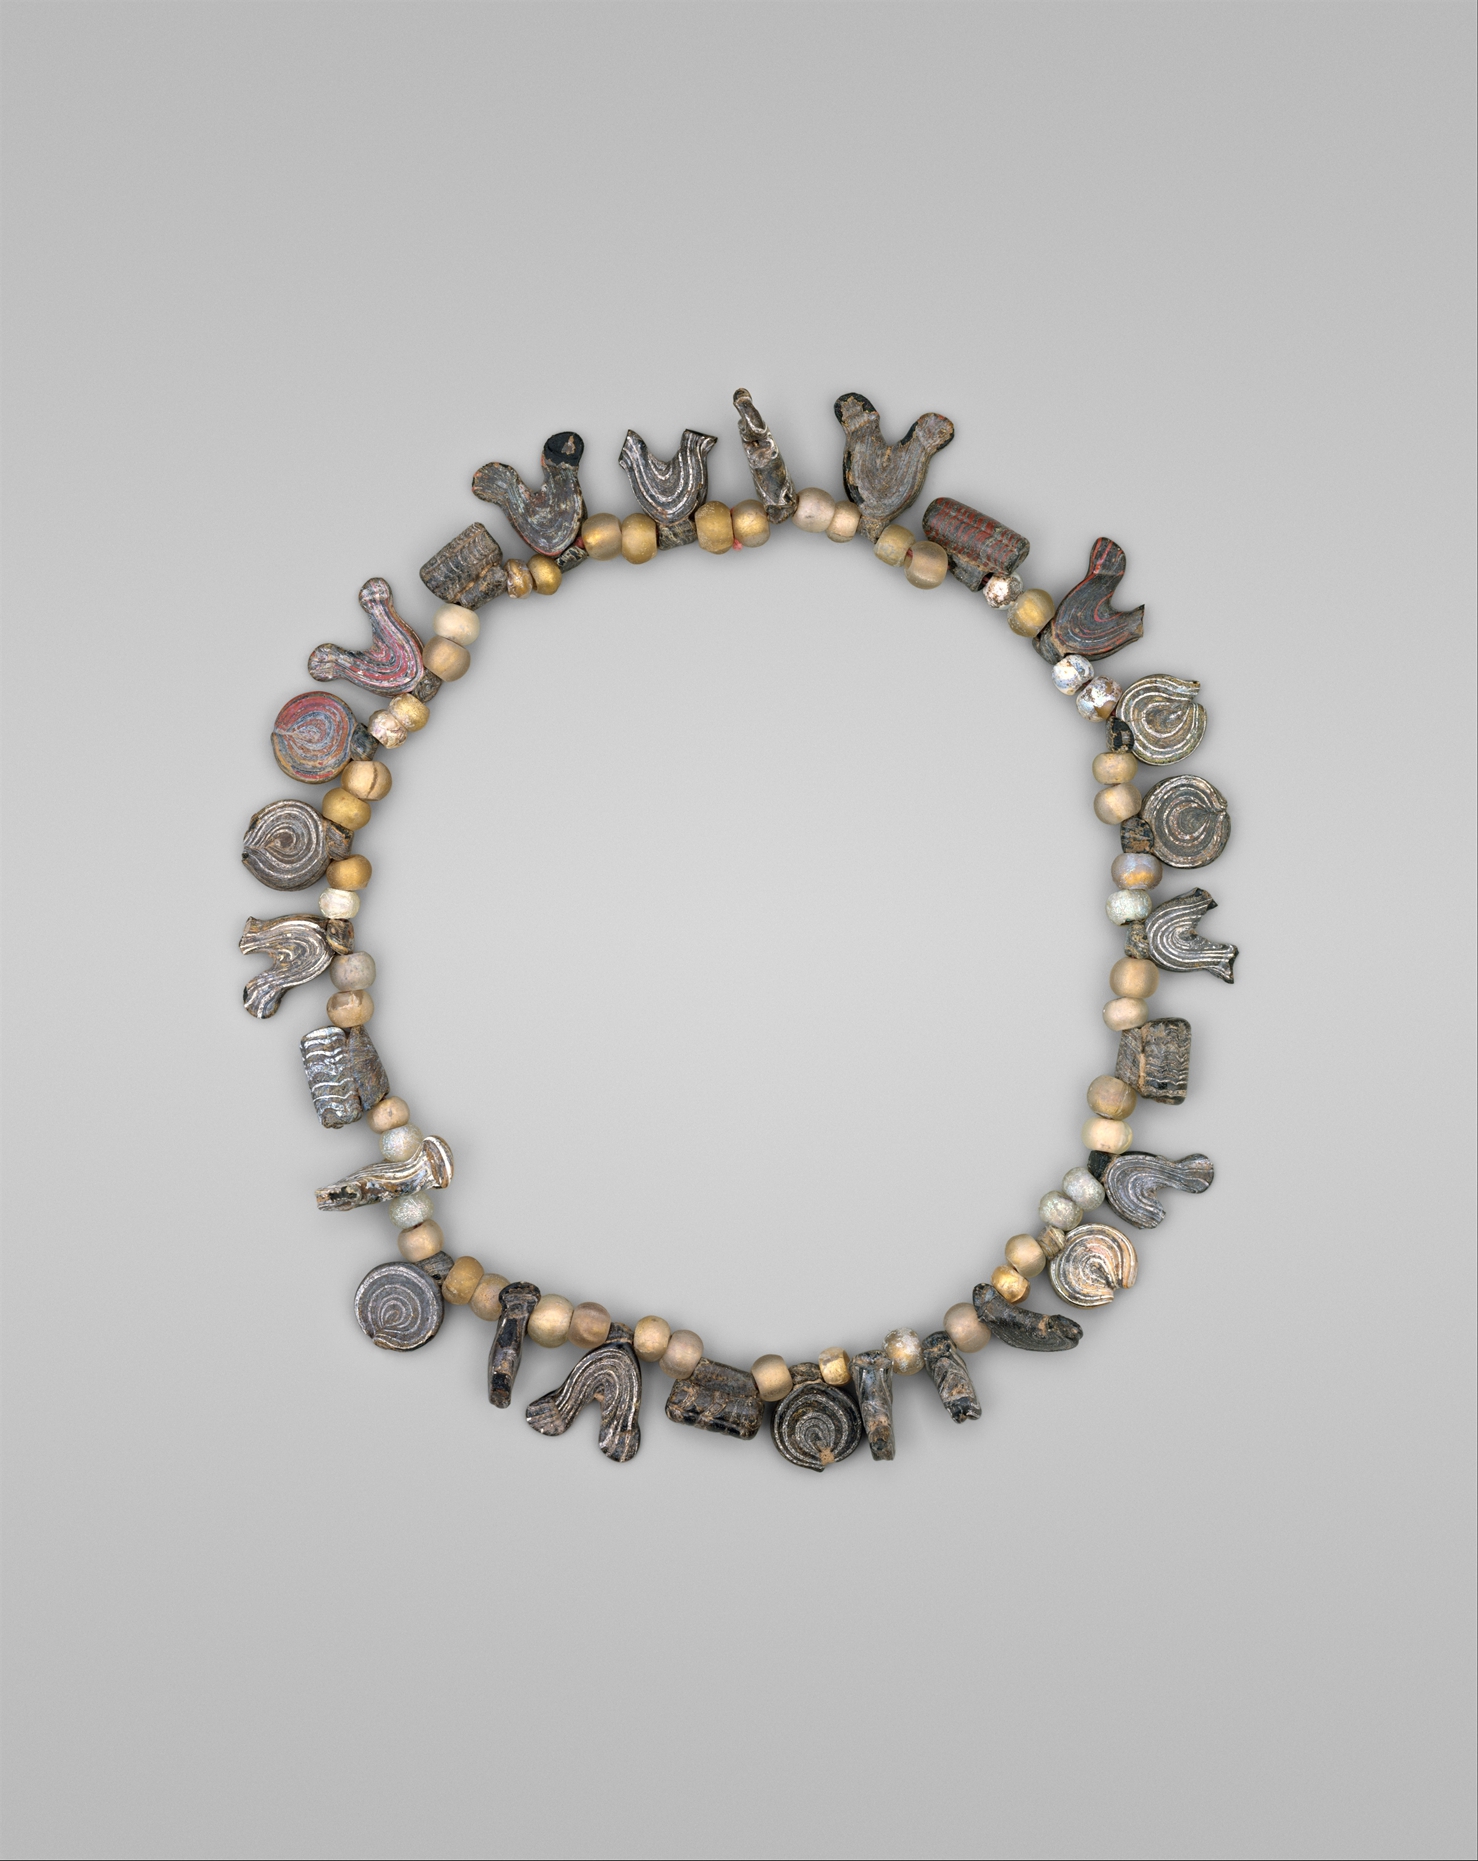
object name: necklace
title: Necklace with Bird, Circle and Cylinder Beads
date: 1001-1200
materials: amber, glass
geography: iran